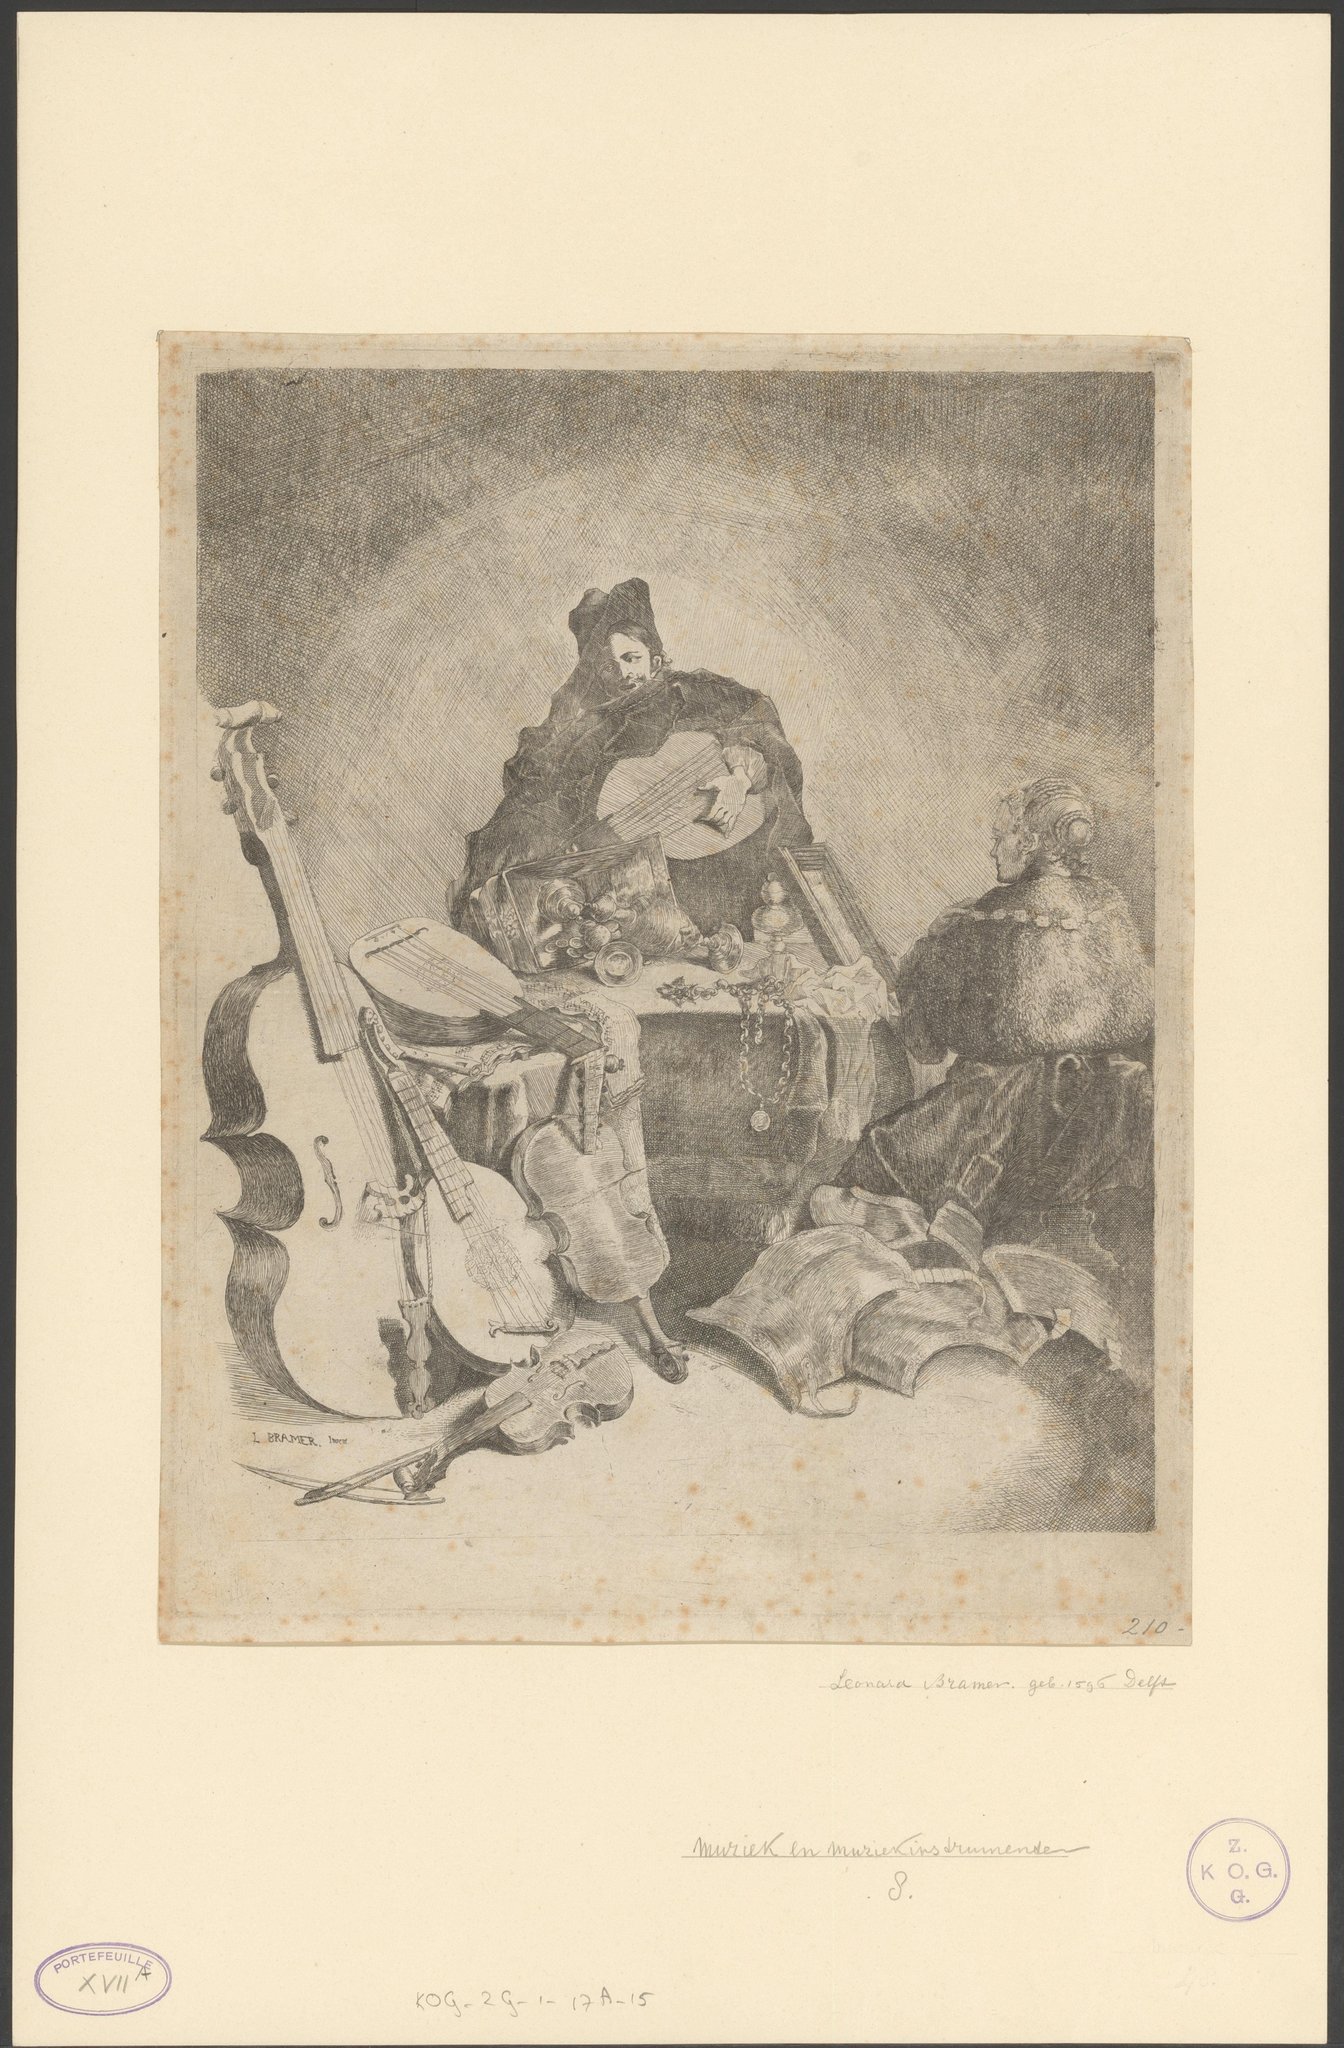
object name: print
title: De luitspeler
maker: leonaert bramer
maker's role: draughtsman, painter, print maker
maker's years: 1596-1674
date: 1635-1674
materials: paper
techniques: drypoint, etching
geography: netherlands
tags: armour, person(s) sitting among objects forming a 'vanitas' still life, string instruments (plucked), one person playing string instrument (plucked), string instruments (bowed)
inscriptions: collector's mark: Lugt 1641, stamp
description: Een man spelend op een luit. Hij staat achter een tafel waarop kostbare metalen kelken en een ketting liggen. Links meerdere strijkinstrumenten op de tafel en op de grond. Rechts van de tafel zit een goed geklede vrouw met een cape van bont om haar schouders in een spiegel te kijken. Op de grond liggen delen van harnassen. Op een muziekblad op tafel het woord: Vanitas. Allegorie op de IJdelheid. Onderwerpsrubrieken binnen de Atlas Zeden en Gewoonten: Muziek en muziekinstrumenten: Strijk- en snaarinstrumenten.